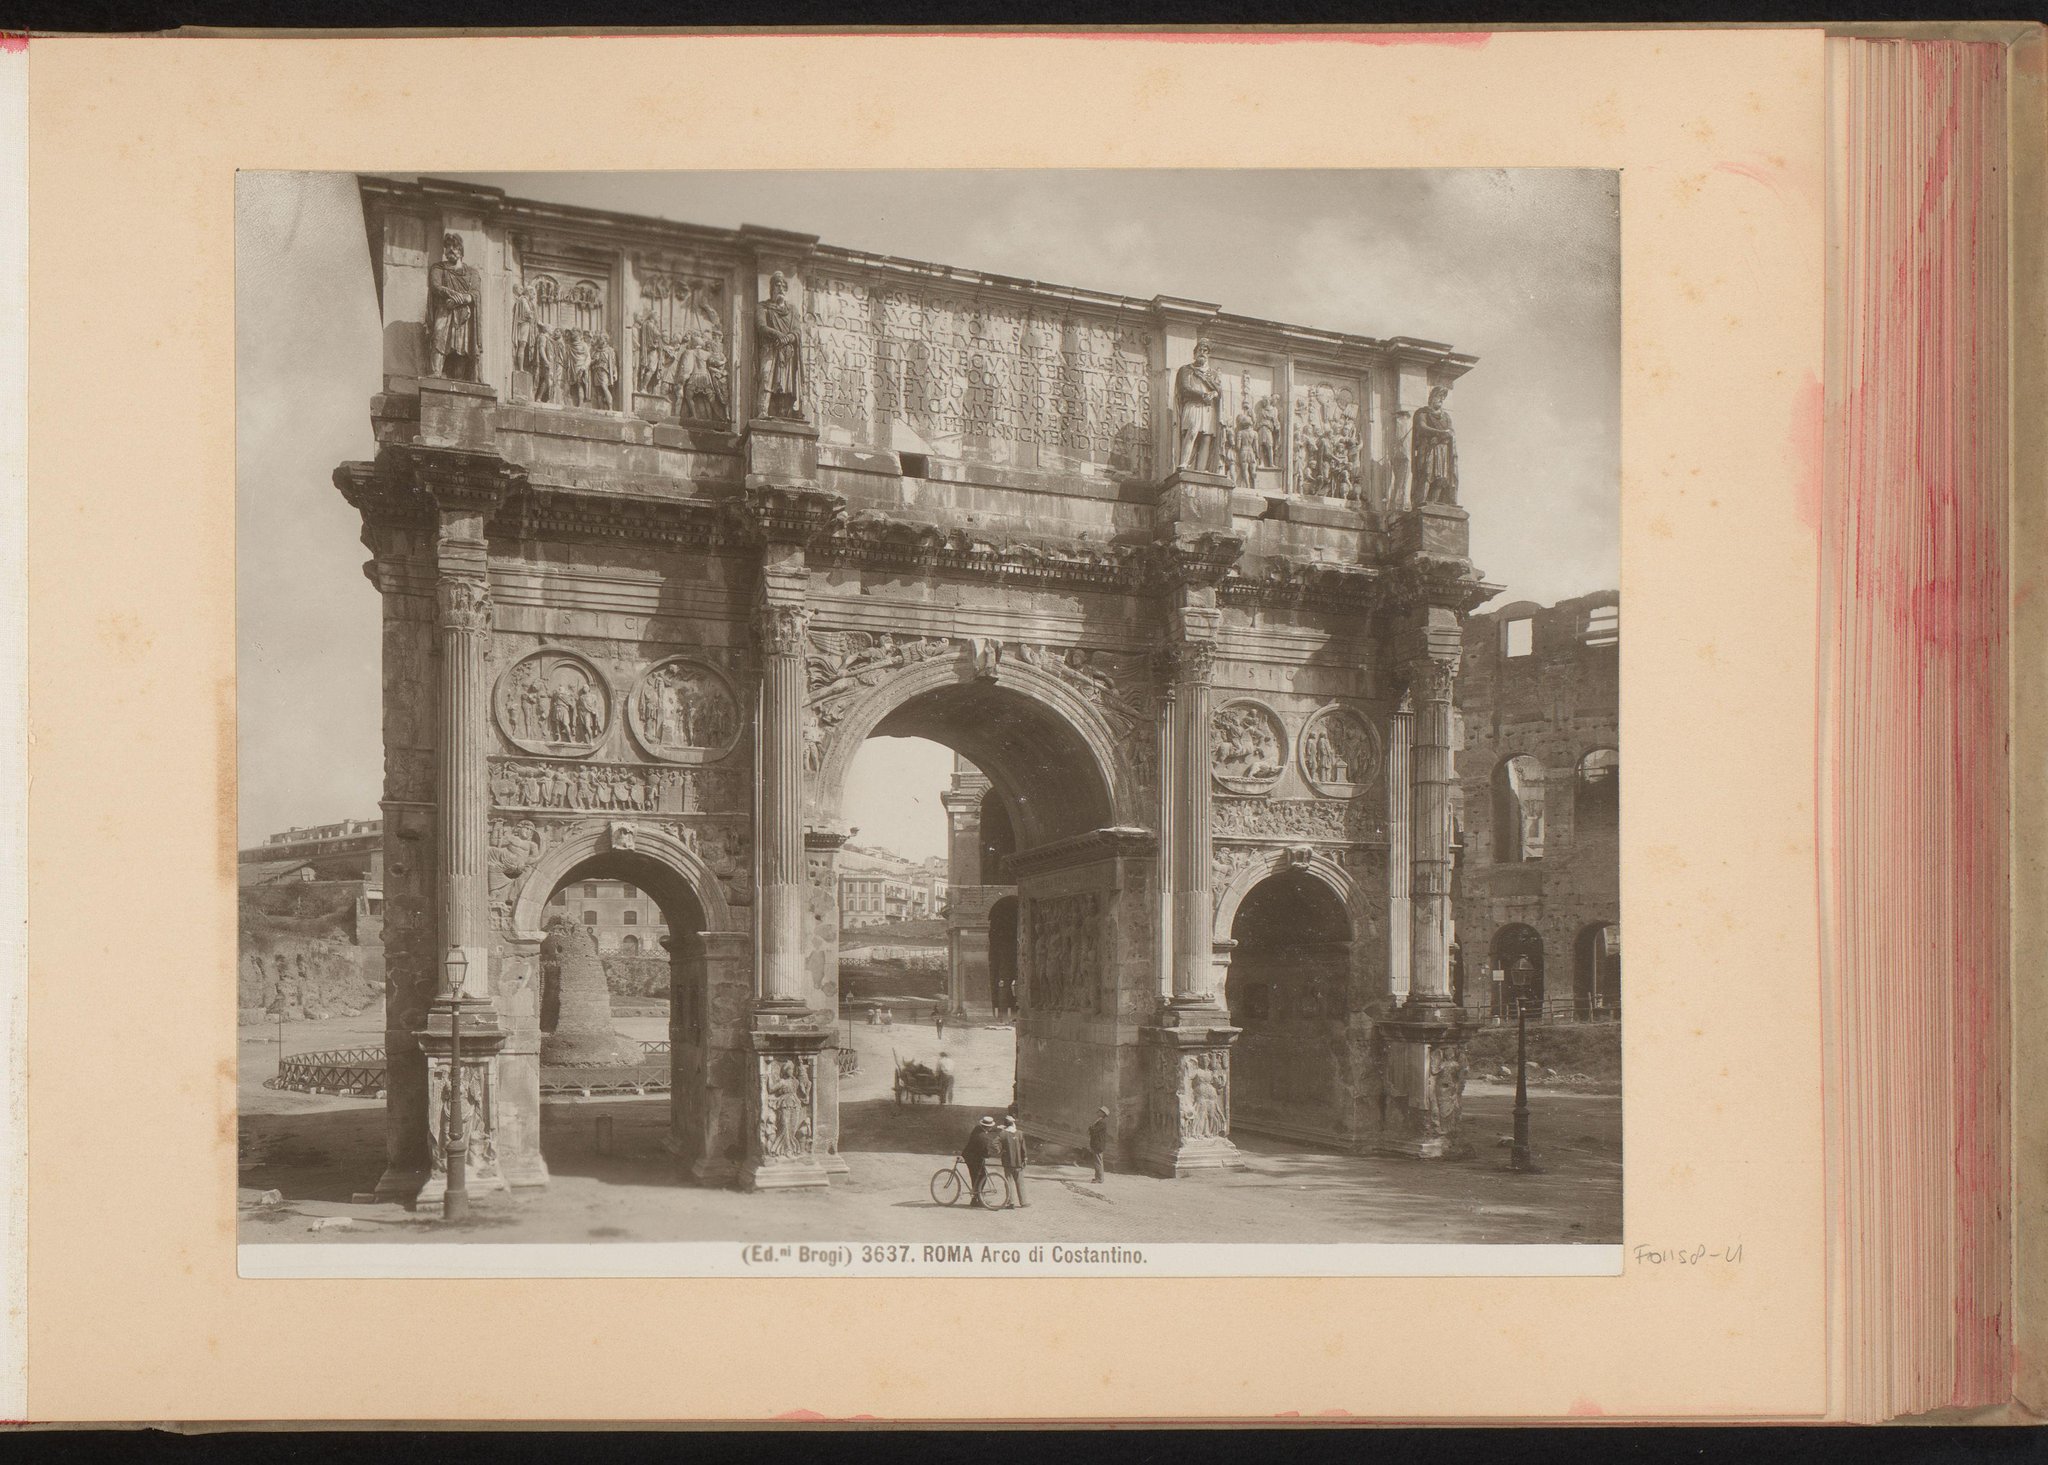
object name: photograph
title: Roma Arco di Costantino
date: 1875-1907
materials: photographic support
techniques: gelatin silver print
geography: rome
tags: triumphal arch, arch of constantine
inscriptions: number: ‘3637’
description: Onderdeel van Fotoalbum met opnames van bezienswaardigheden en kunstwerken in Italië.